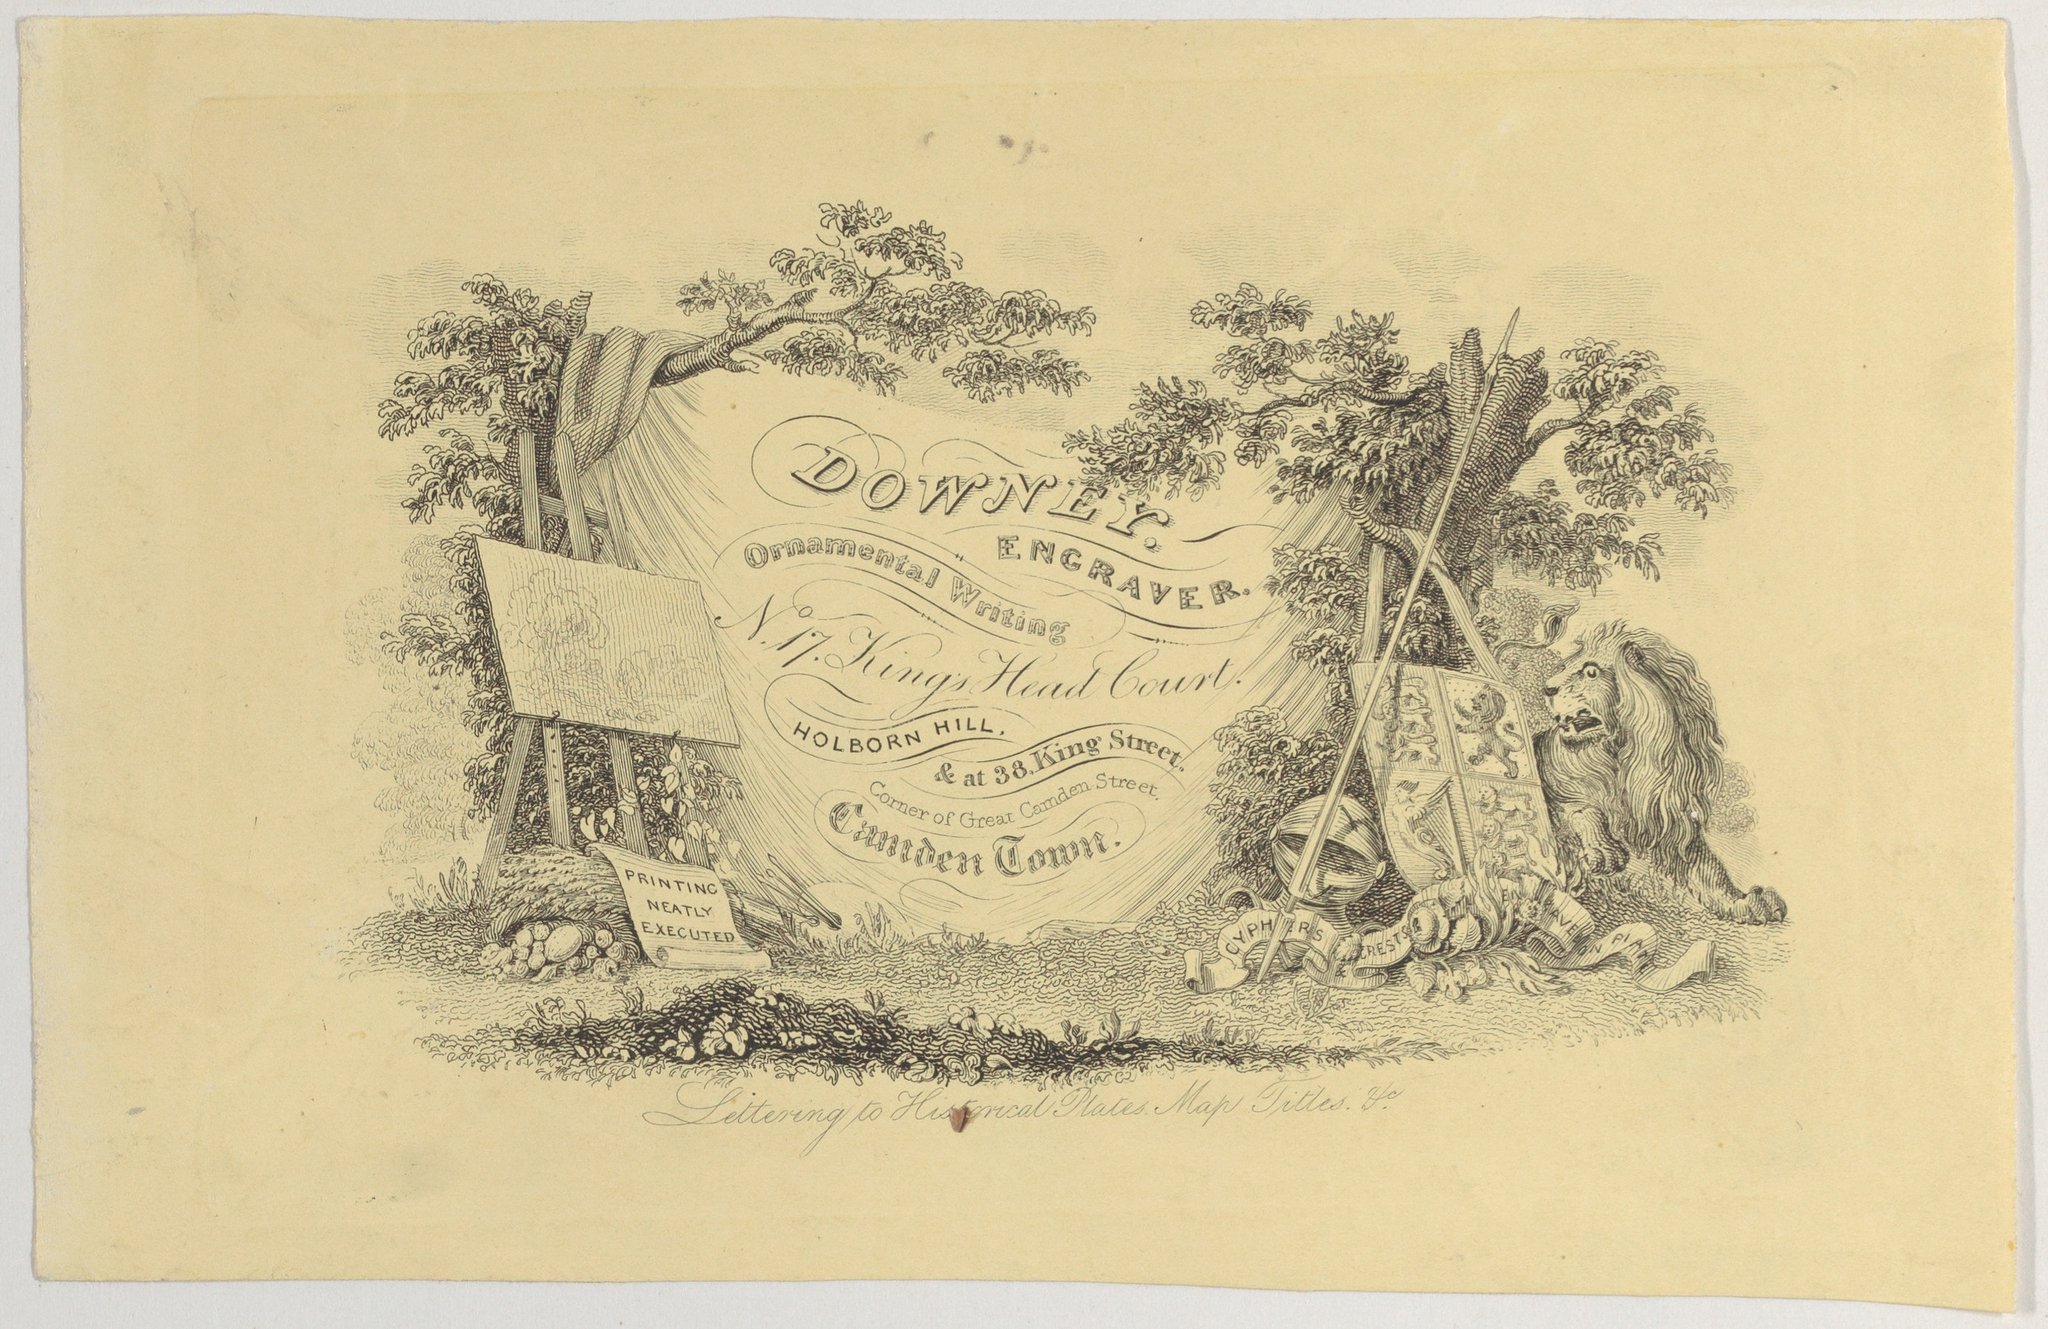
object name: print, trade card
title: Trade Card for Downey, engraver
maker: anonymous, british, 19th century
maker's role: artist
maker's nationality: british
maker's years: 1800-1900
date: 1801-1900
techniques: engraving